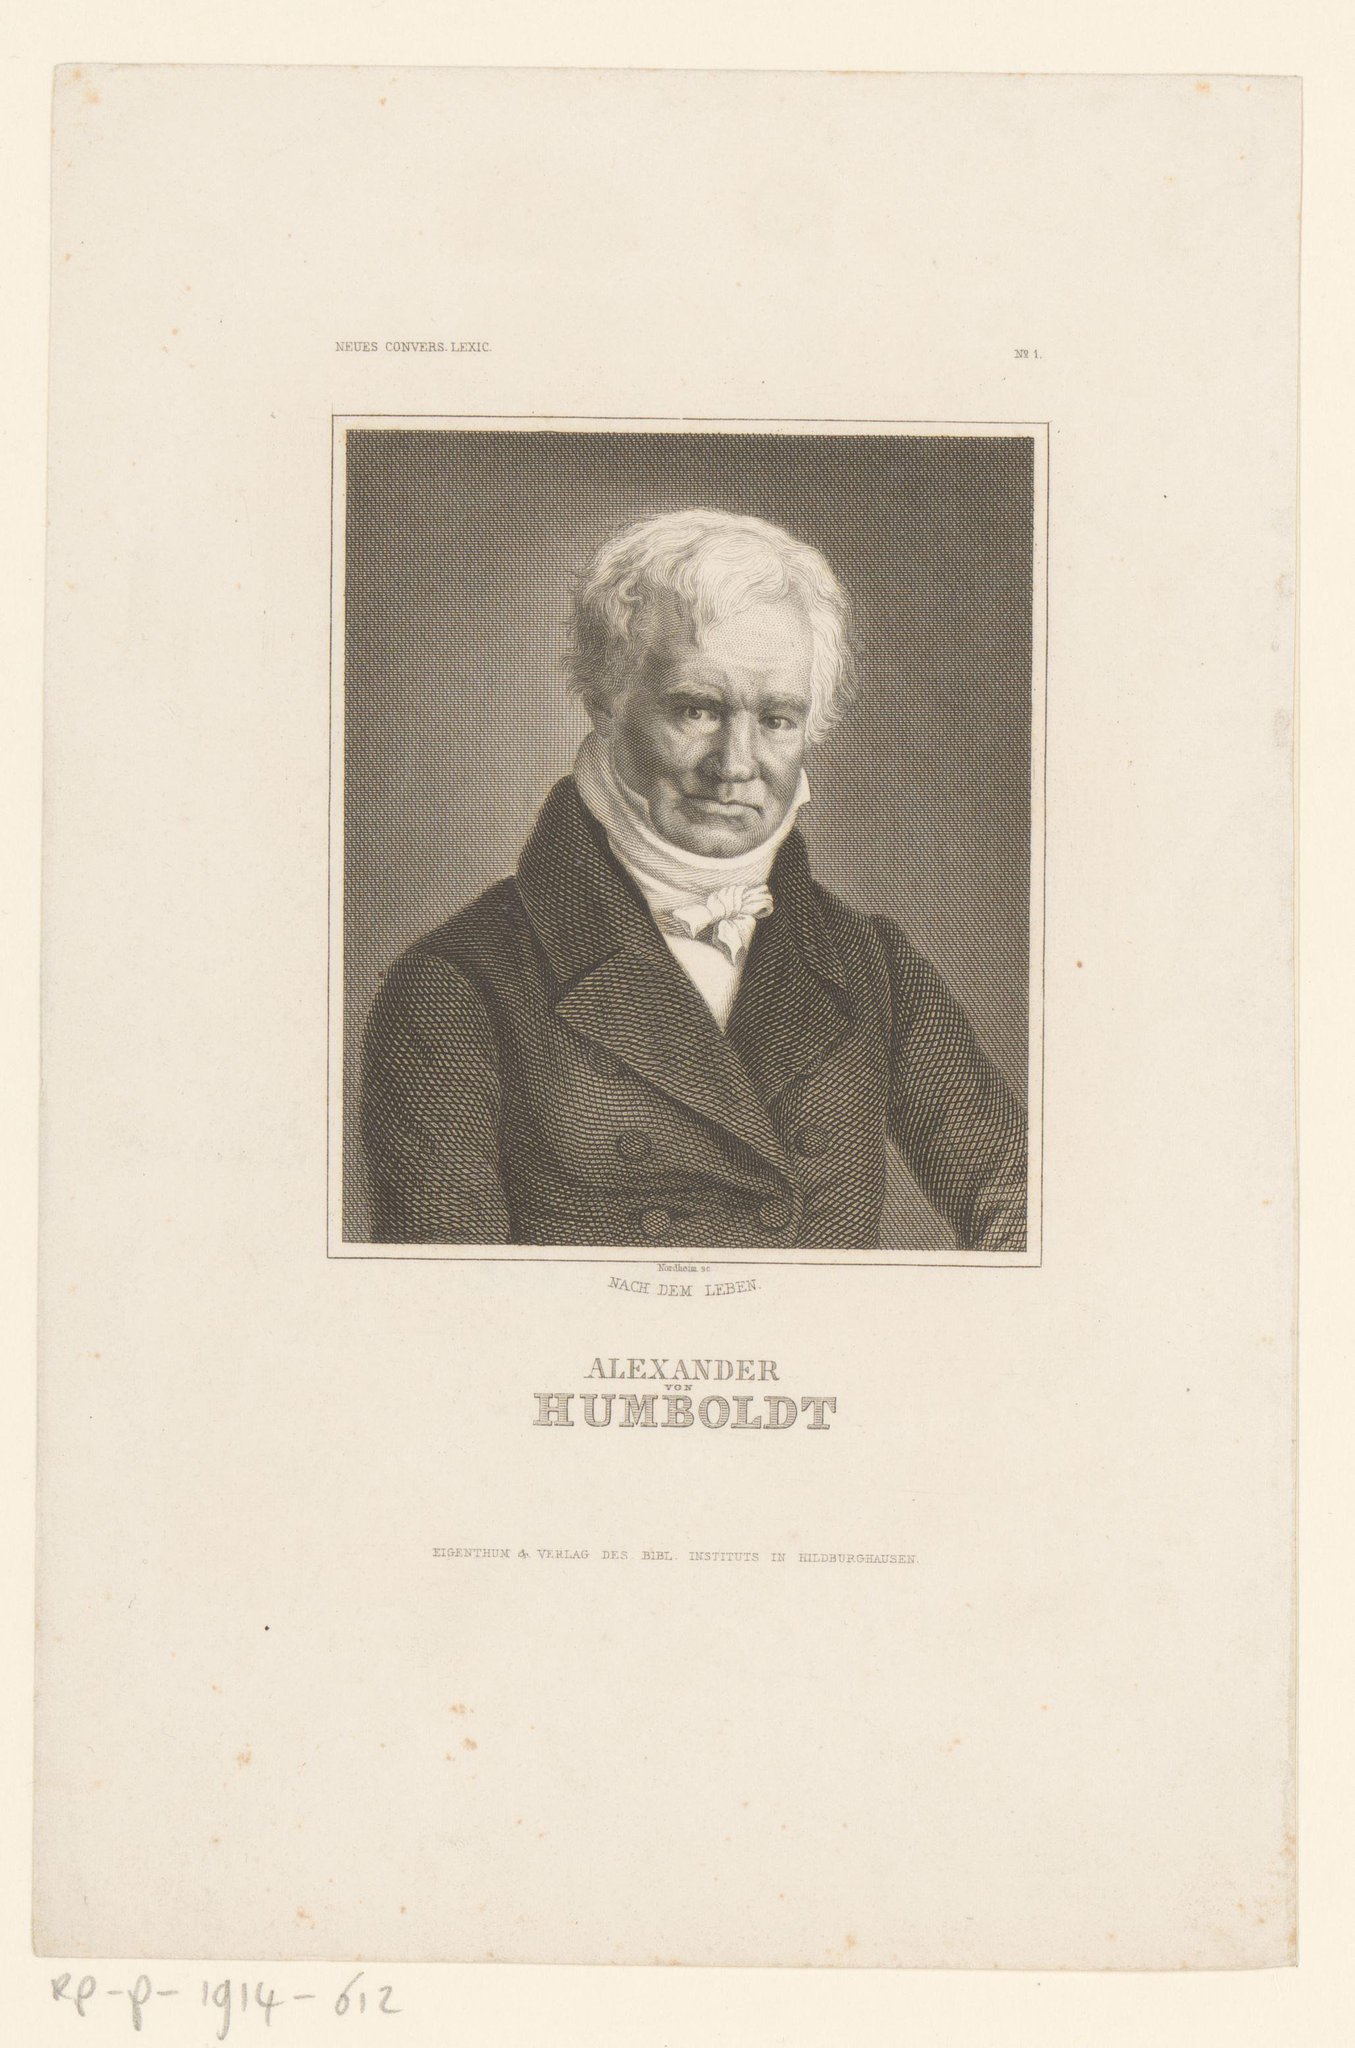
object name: print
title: Portret van Alexander von Humboldt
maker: johann georg nordheim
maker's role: print maker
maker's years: 1804-1853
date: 1857-1861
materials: paper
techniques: engraving, etching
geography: hildburghausen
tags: traveler, historical persons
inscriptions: collector's mark: Lugt 2228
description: Prent afkomstig uit: Neues Conversations-Lexikon für alle Stände, voor het eerst uitgegeven tussen 1857-1861.